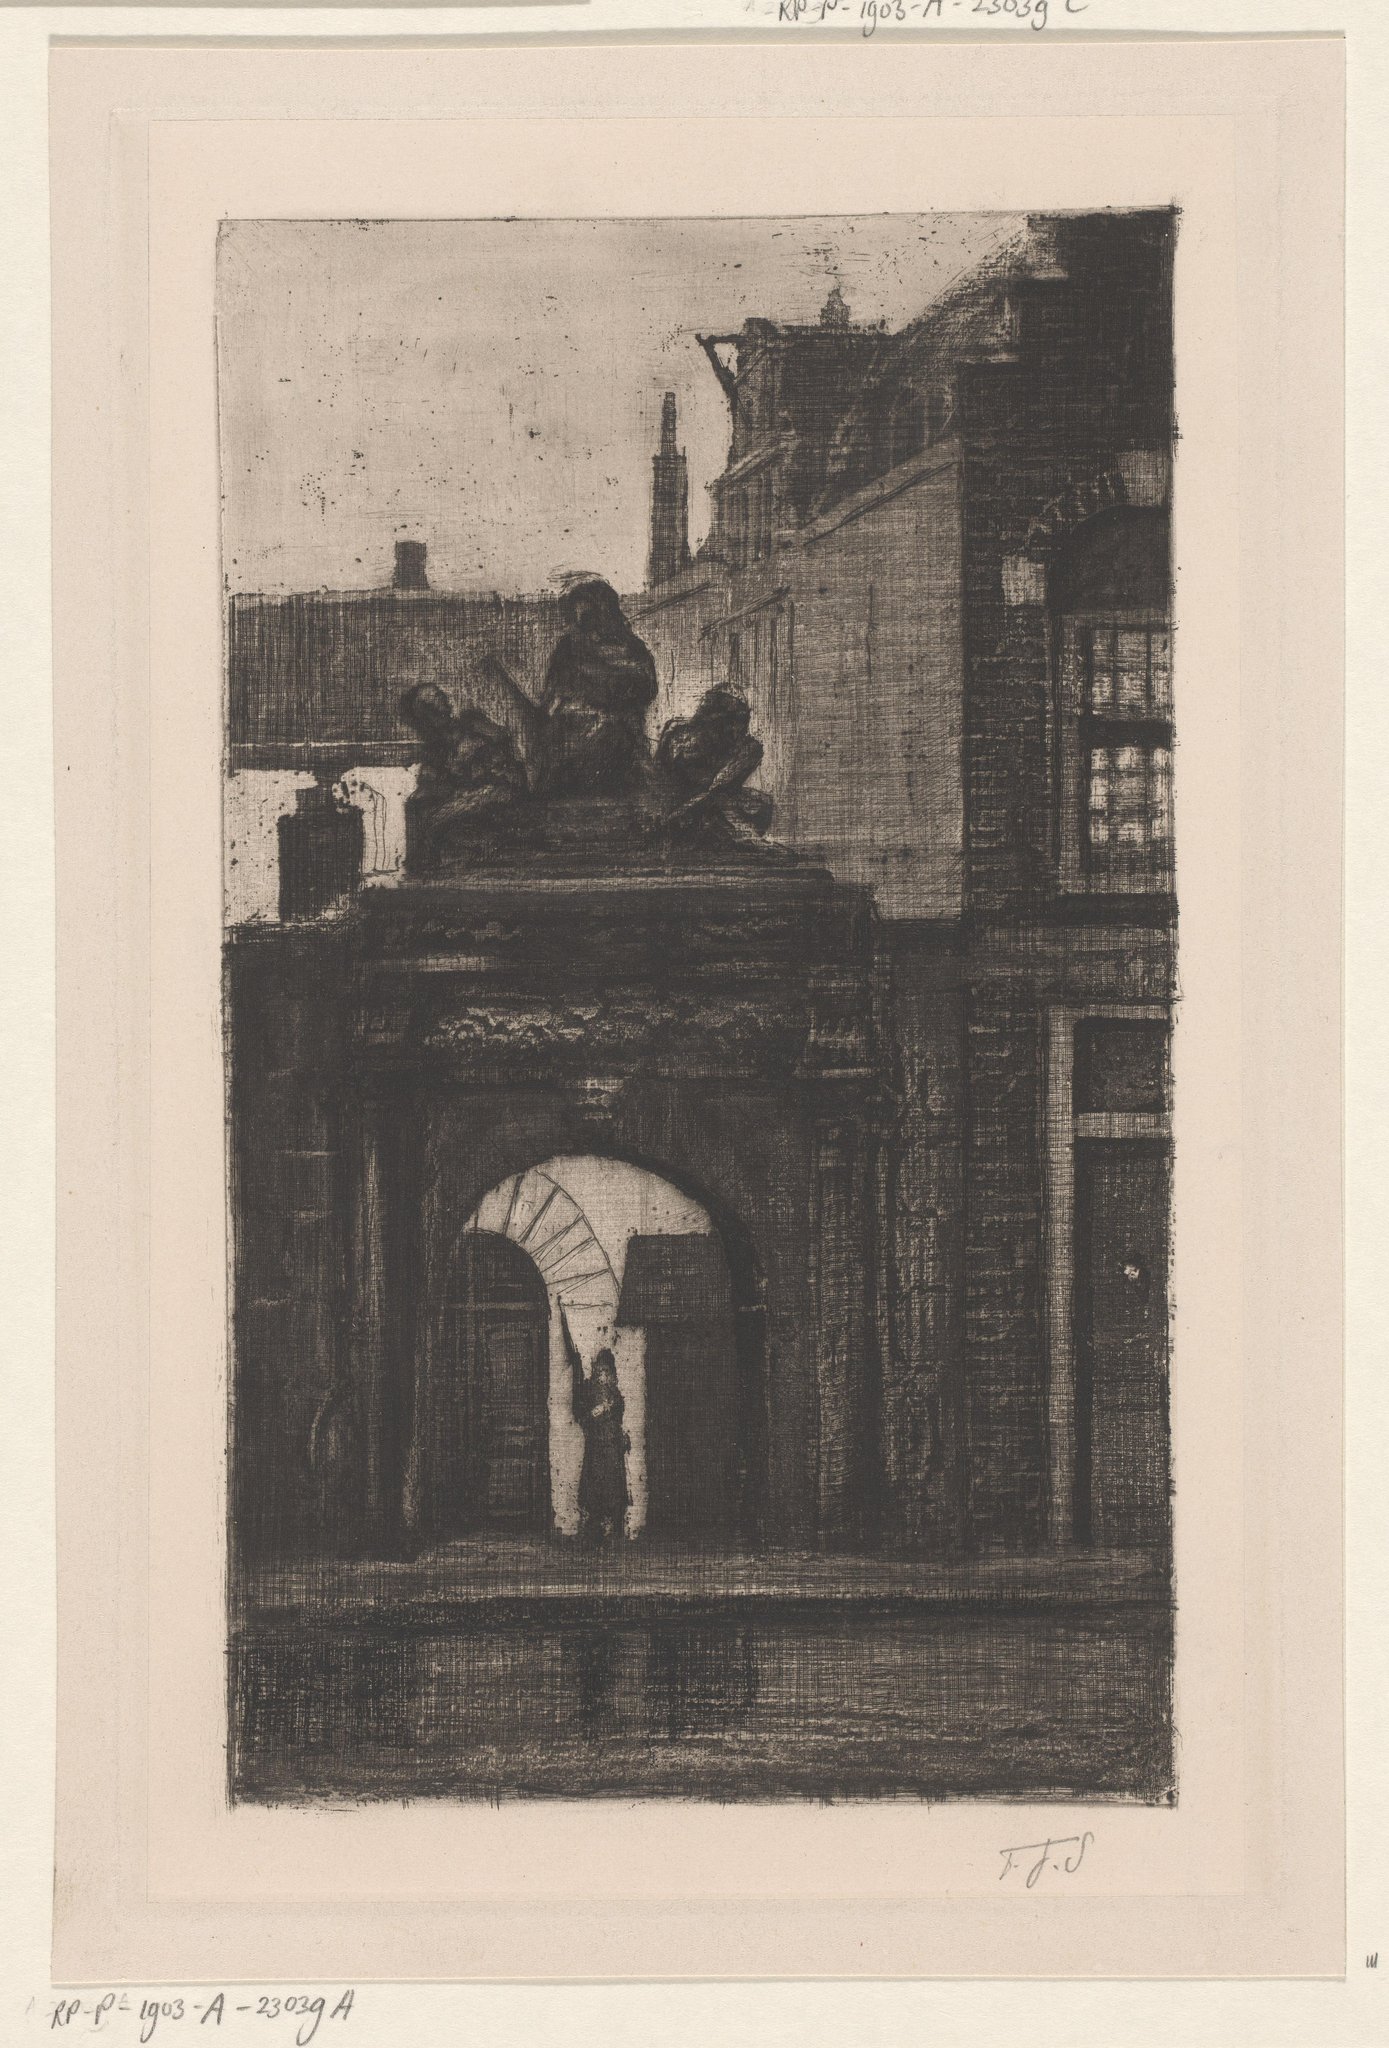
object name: print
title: Poort van het Tucht- of Rasphuis te Amsterdam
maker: frans schikkinger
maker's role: print maker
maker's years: 1838-1902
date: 1848-1902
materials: paper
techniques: drypoint, etching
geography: amsterdam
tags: rasphuis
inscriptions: collector's mark: Lugt 2228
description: De poort van het Tucht- of Rasphuis aan de Heiligeweg in Amsterdam. Bij de deur een wachthuisje, waarbij een soldaat met geweer.